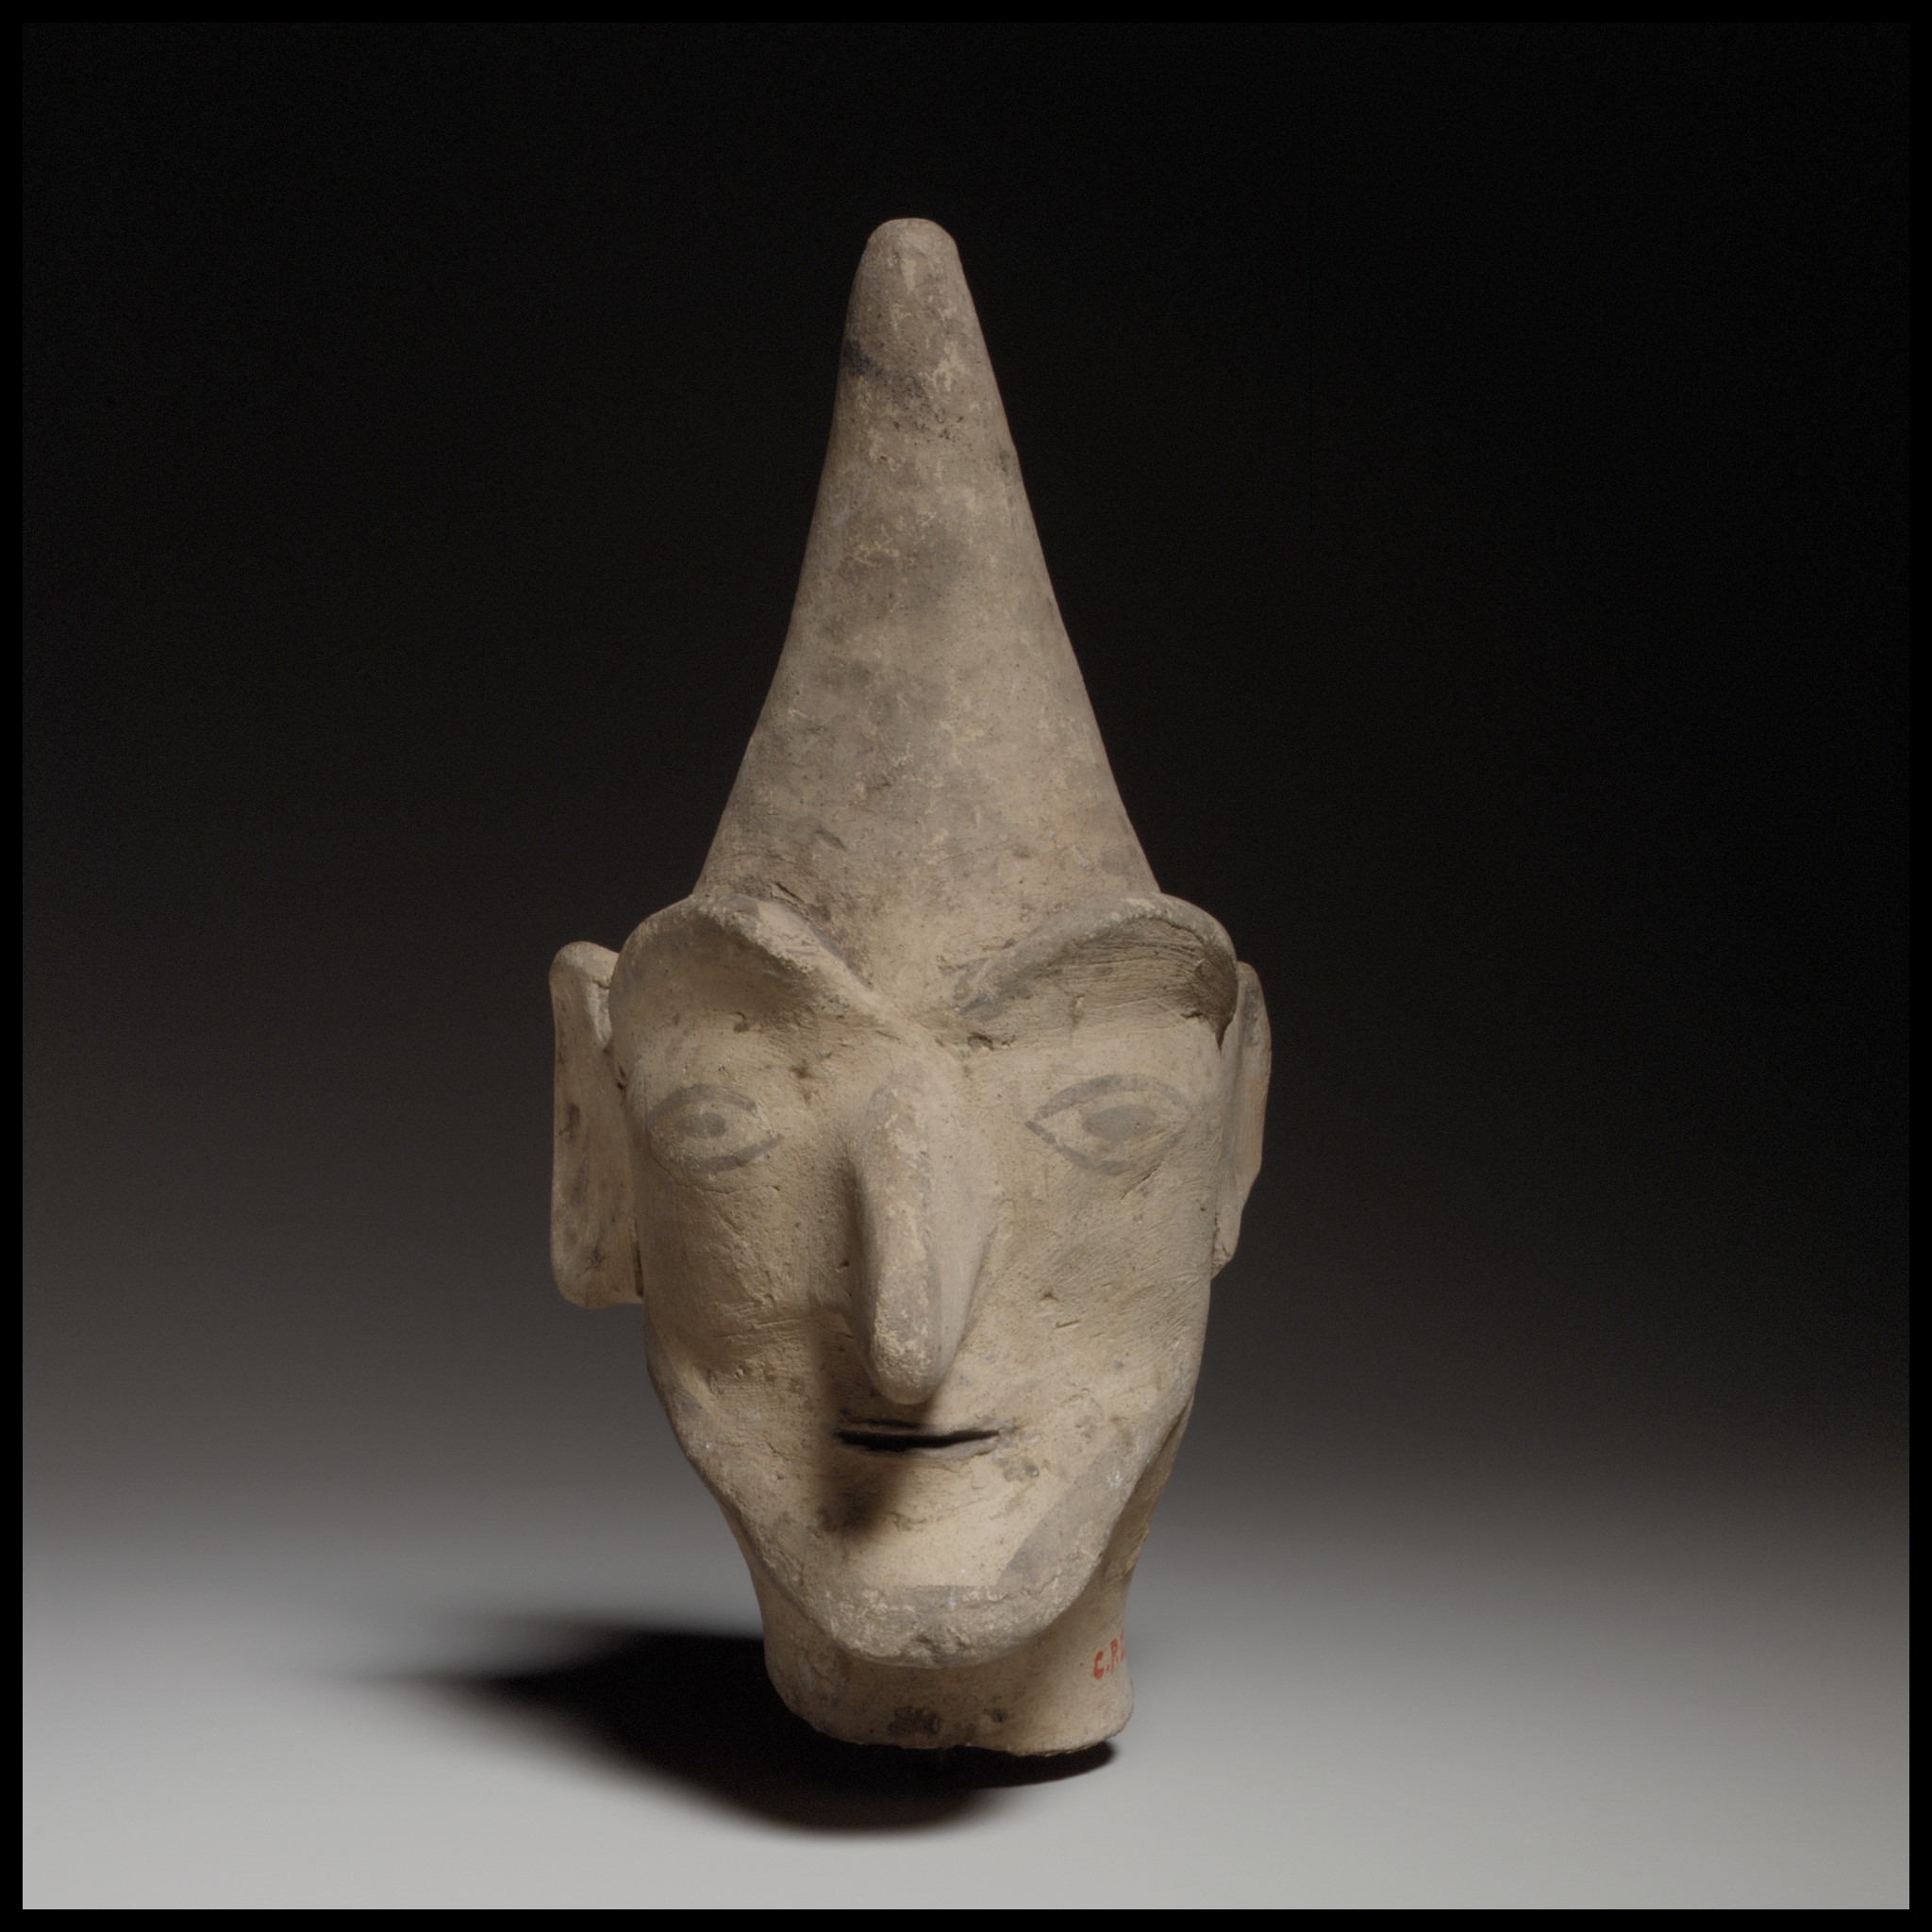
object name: head of a warrior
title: Male head wearing a helmet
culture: cypriot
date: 600 BCE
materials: terracotta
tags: helmets,heads,men